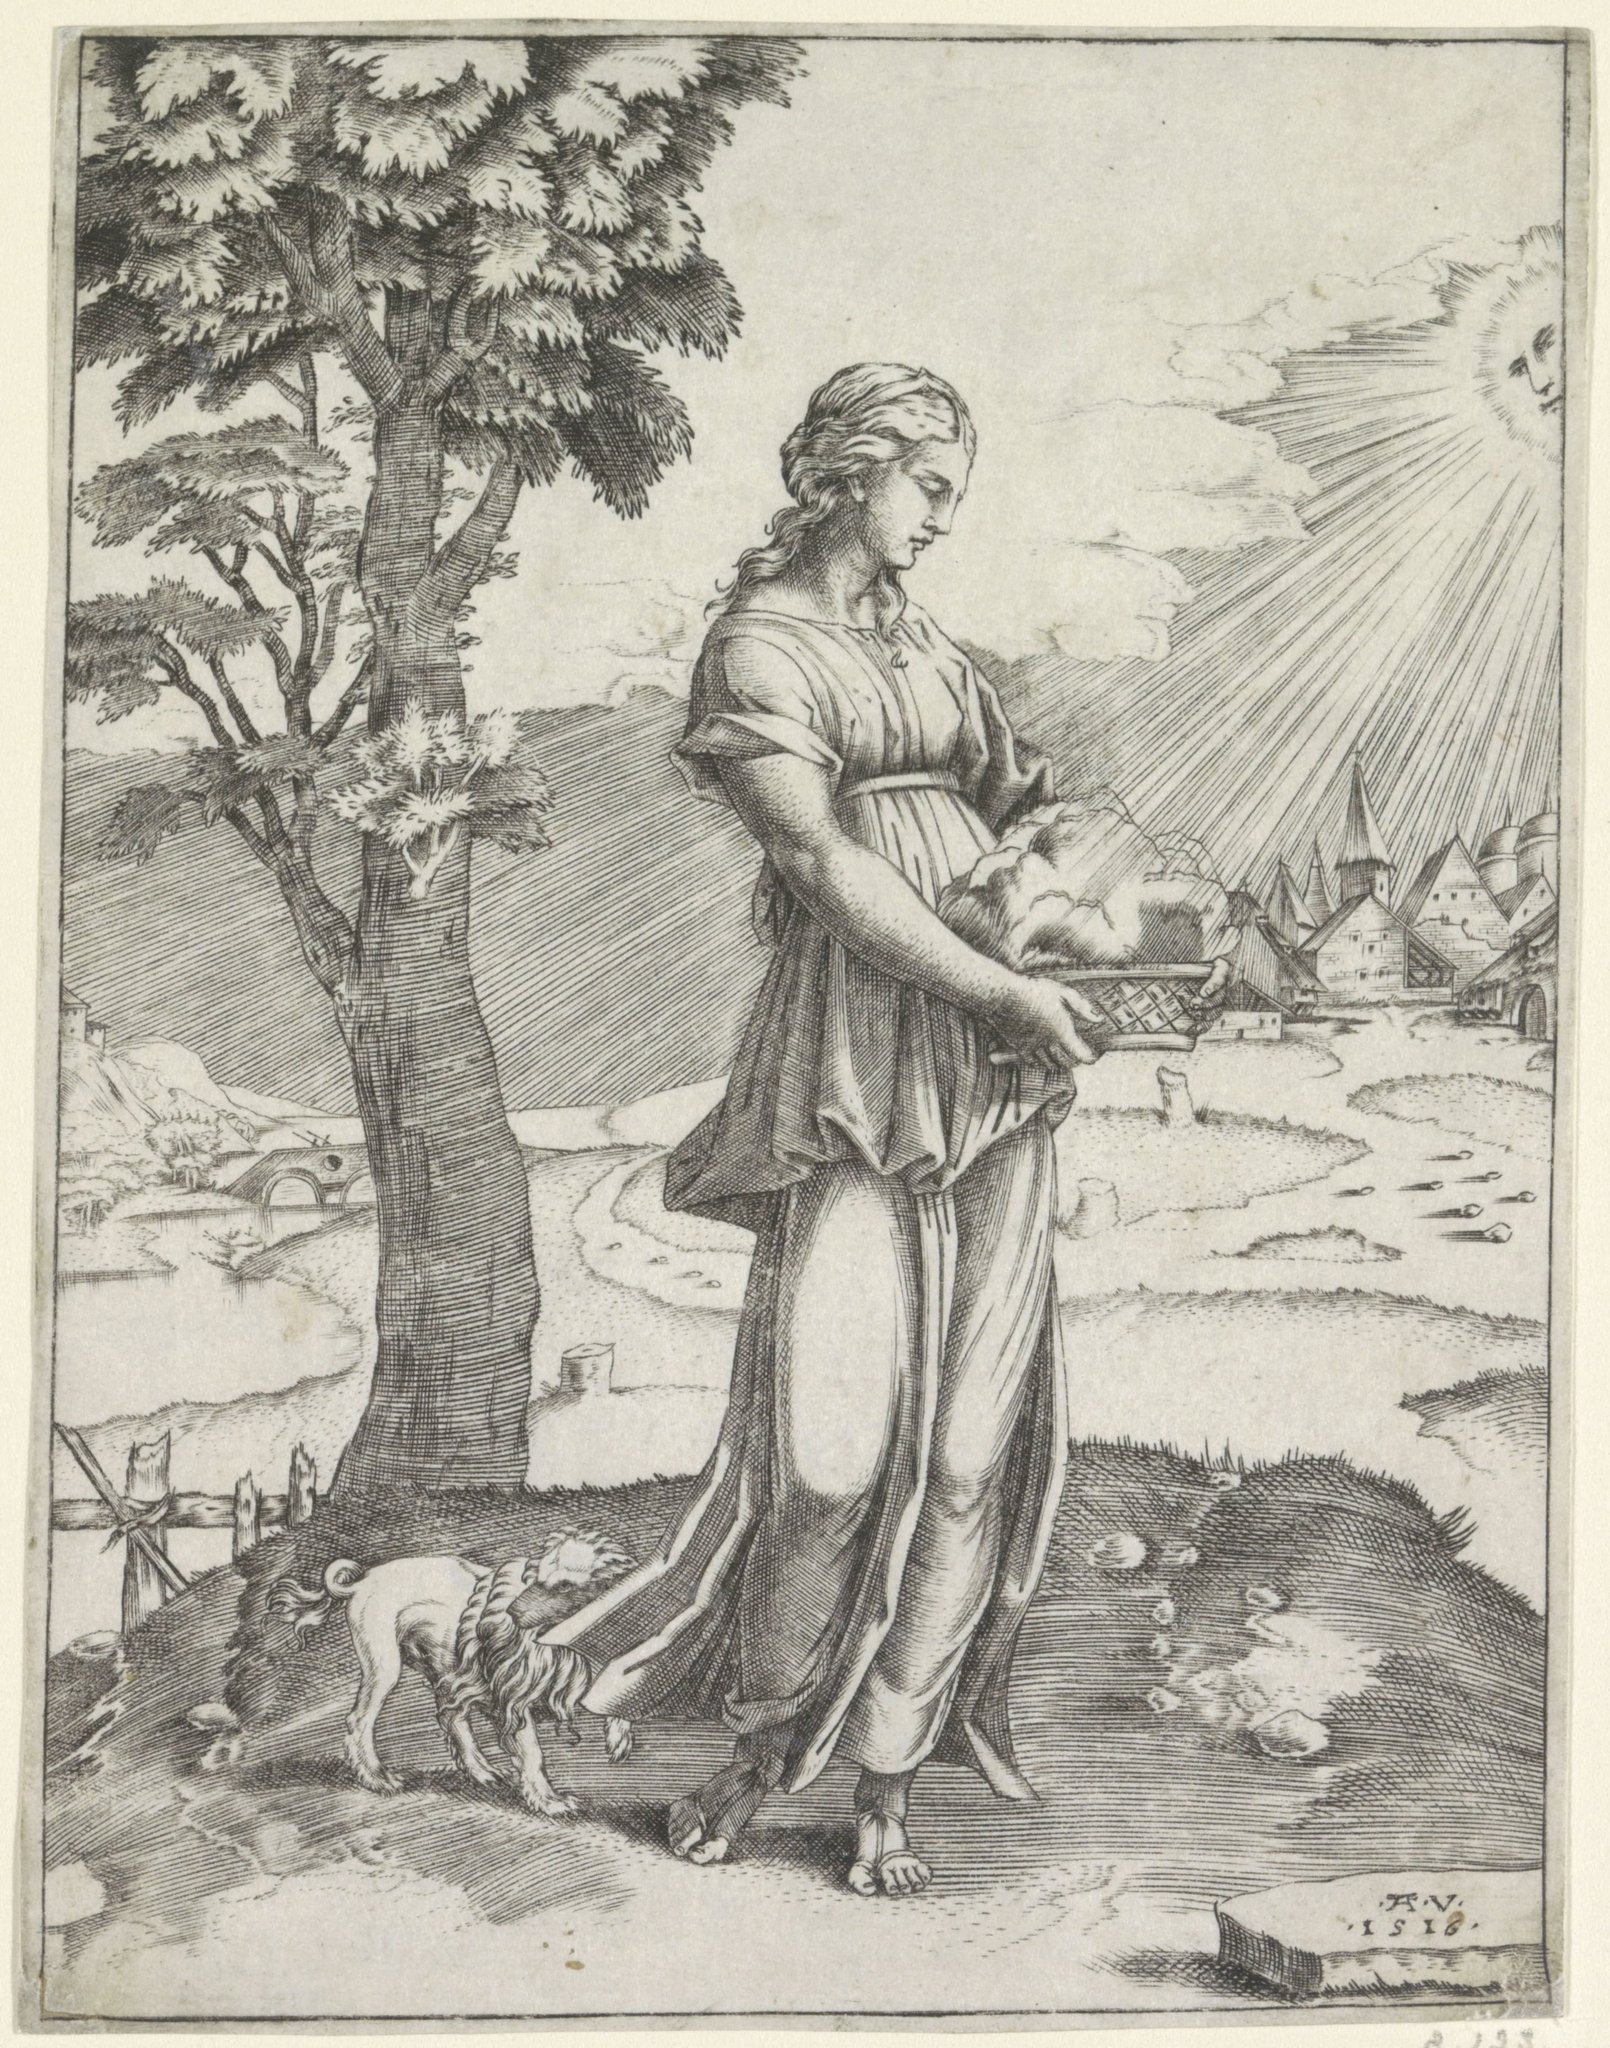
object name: print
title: Sibille van Cumae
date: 1516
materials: paper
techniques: engraving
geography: italy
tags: cumaean sibyl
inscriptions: collector's mark: Lugt 2228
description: De Sibille van Cumae staat in een landschap met een mand vol zand in haar handen. Apollo schonk haar voor elke zandkorrel een levensjaar. Links naast haar staat een hond. In de achtergrond een dorp aan een rivier.